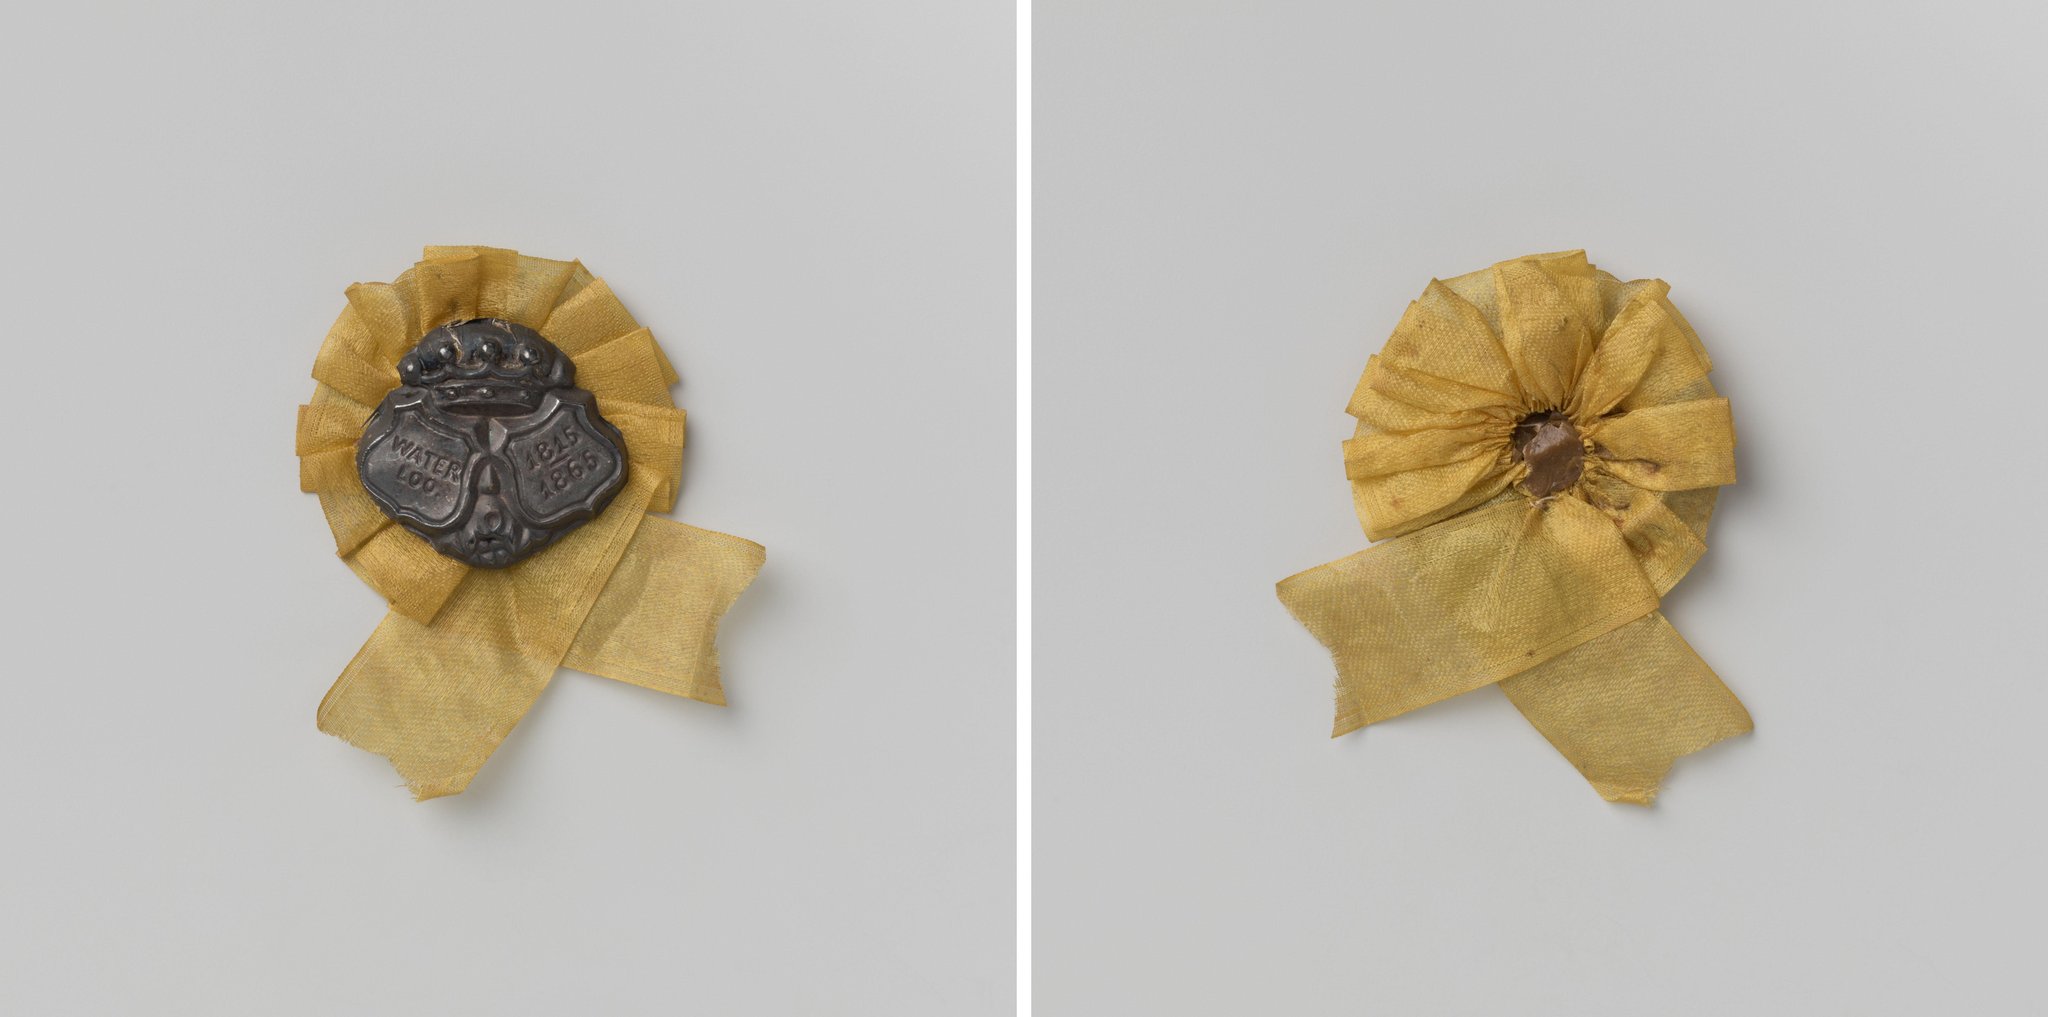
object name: insignia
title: Vijftigjarige viering van slag bij Waterloo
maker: Anonymous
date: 1865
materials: silver, textile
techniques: striking, weave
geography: netherlands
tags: waterloo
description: Eenzijdig zilveren draagteken op rozet van geplooid geel textiel, waarvan twee linten afhangen; daarop metalen schild bestaand uit twee tegen elkaar leunende schilden onder kroon, van elkaar gescheiden door ornament